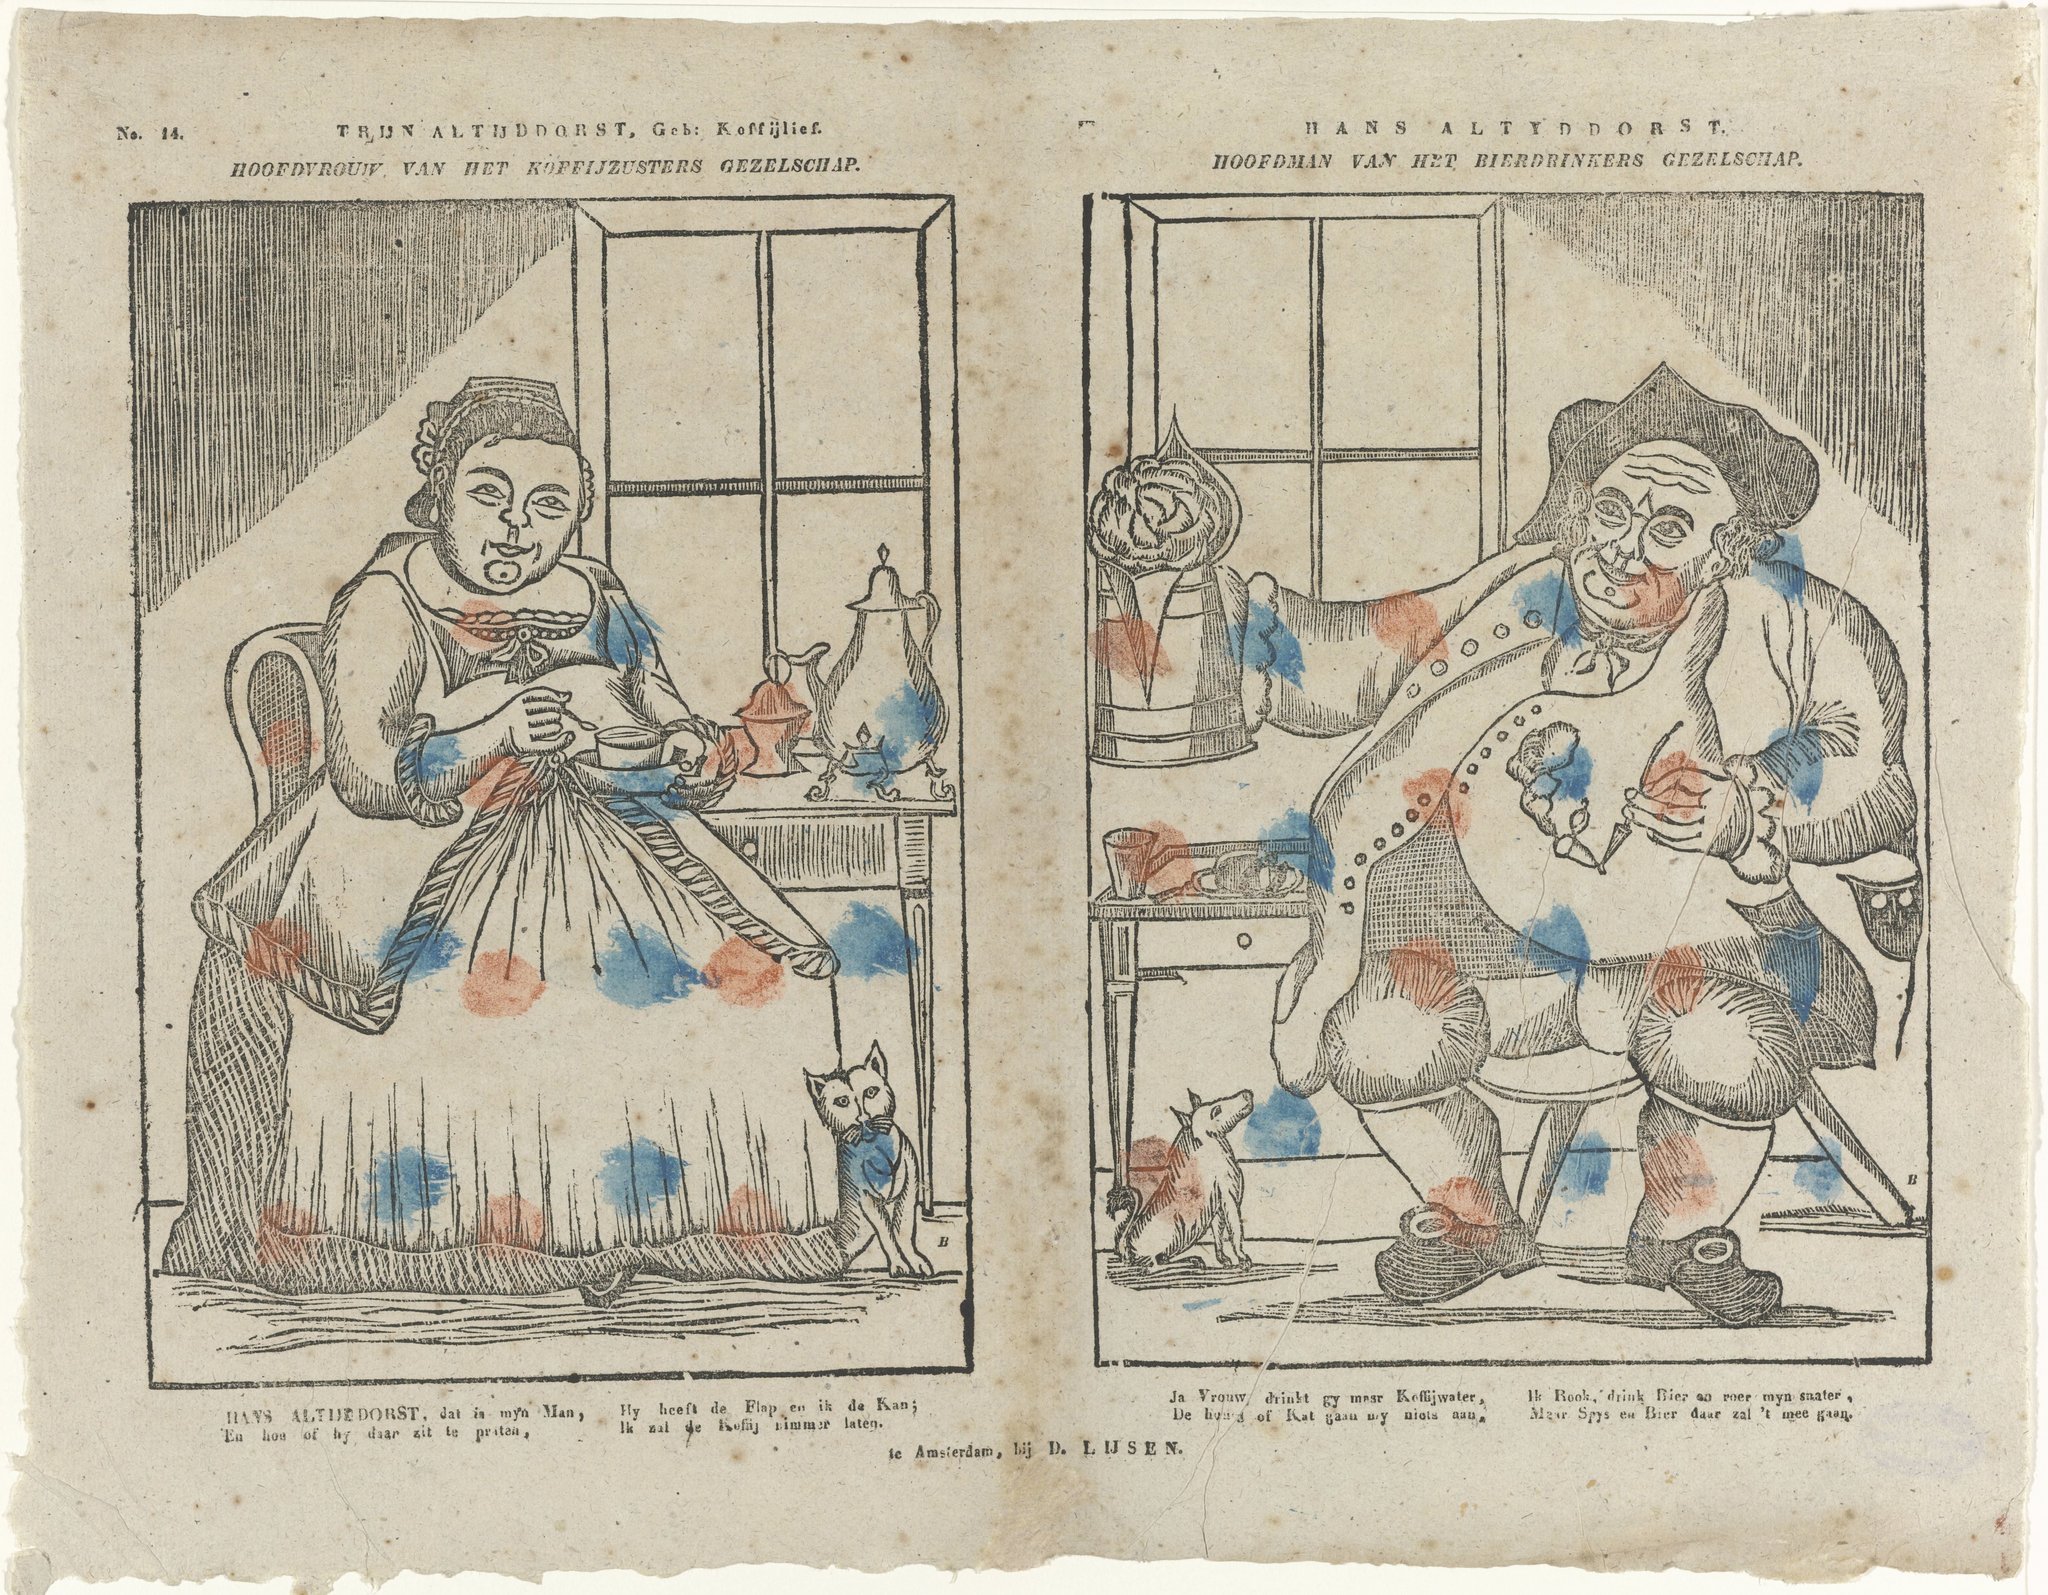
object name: print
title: Trijn Antijddorst, Geb: Koffijlief. / Hoofdvrouw van het koffijzusters gezelschap. / Hans Altyddorst. / Hoofdman van het bierdrinkers gezelschap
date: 1836-1849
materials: paper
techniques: colour, letterpress printing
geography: amsterdam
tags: coffee-pot, mug, beaker, goblet, cup of coffee, beer, ale, drinking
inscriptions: collector's mark: Lugt 2228, collector's mark: ‘Eduard Fuchs / Zehlendorf b. Berlin / Wannseebahn’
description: Blad met 2 voorstellingen. Links Trijn Altijddorst, zittend met een kopje koffie en een lepeltje in haar handen. Aan haar voeten zit een kat. Rechts Hans Altijddorst, zittend met een pijp en een pul bier in zijn handen. Aan zijn voeten zit een hond. Onder elke afbeelding een vierregelig vers. Genummerd linksboven: No. 14.